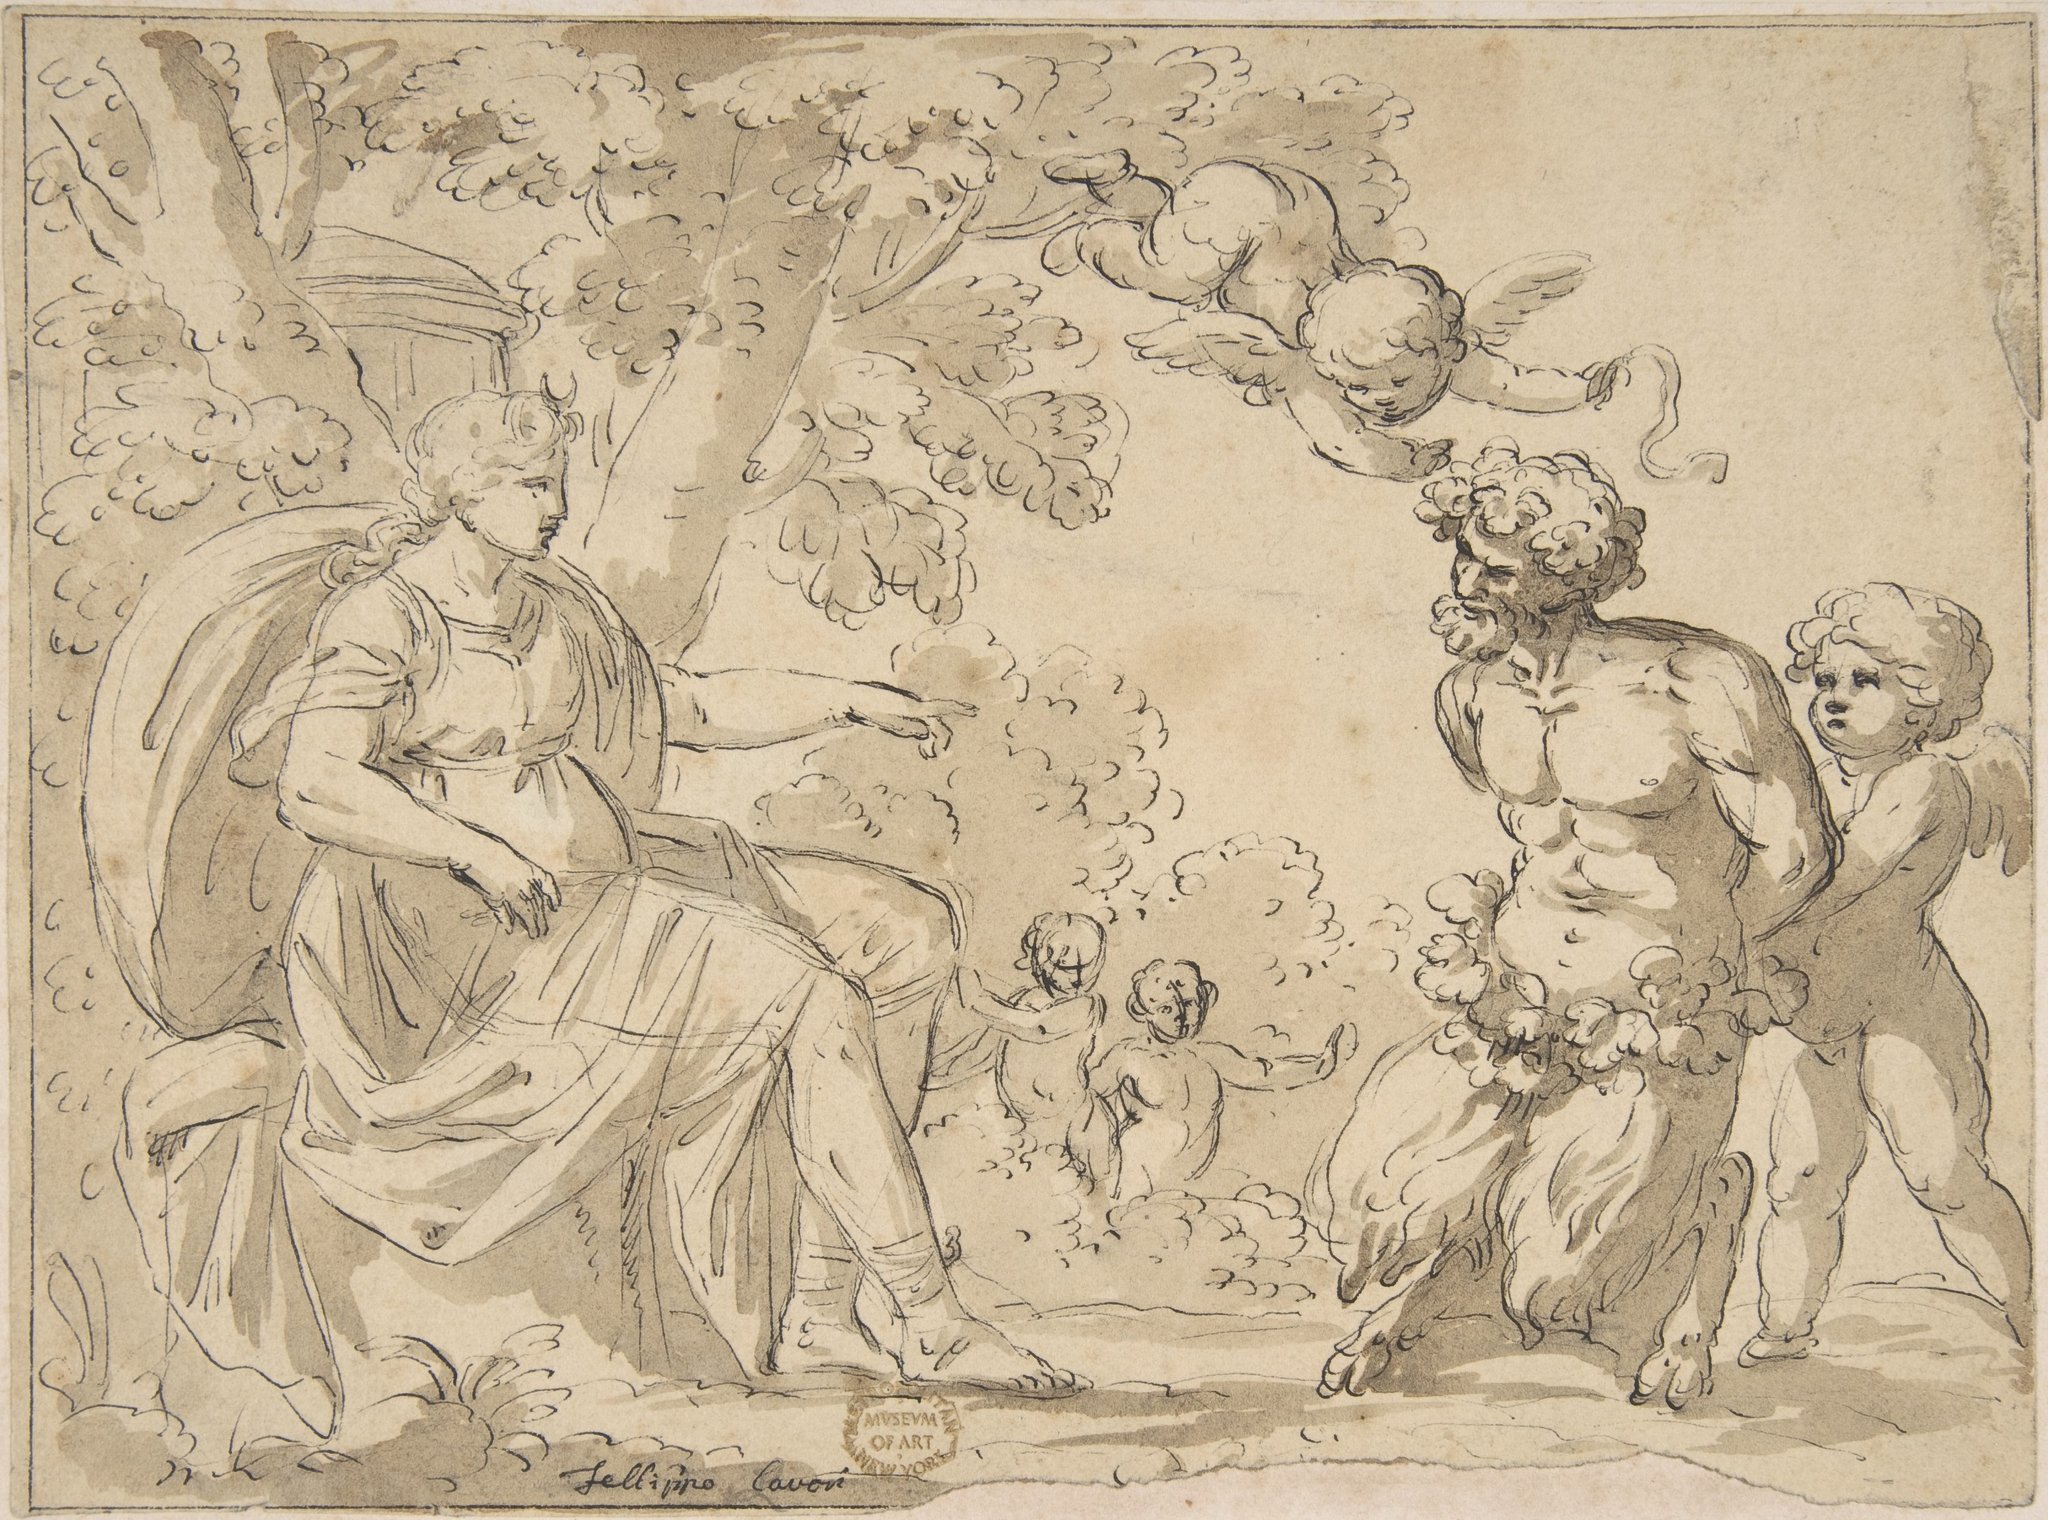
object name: drawing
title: Diana and Satyr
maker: filippo cavori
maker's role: artist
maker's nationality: italian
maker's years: 1800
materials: ink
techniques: brush, pen, wash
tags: diana,satyrs,trees,angels